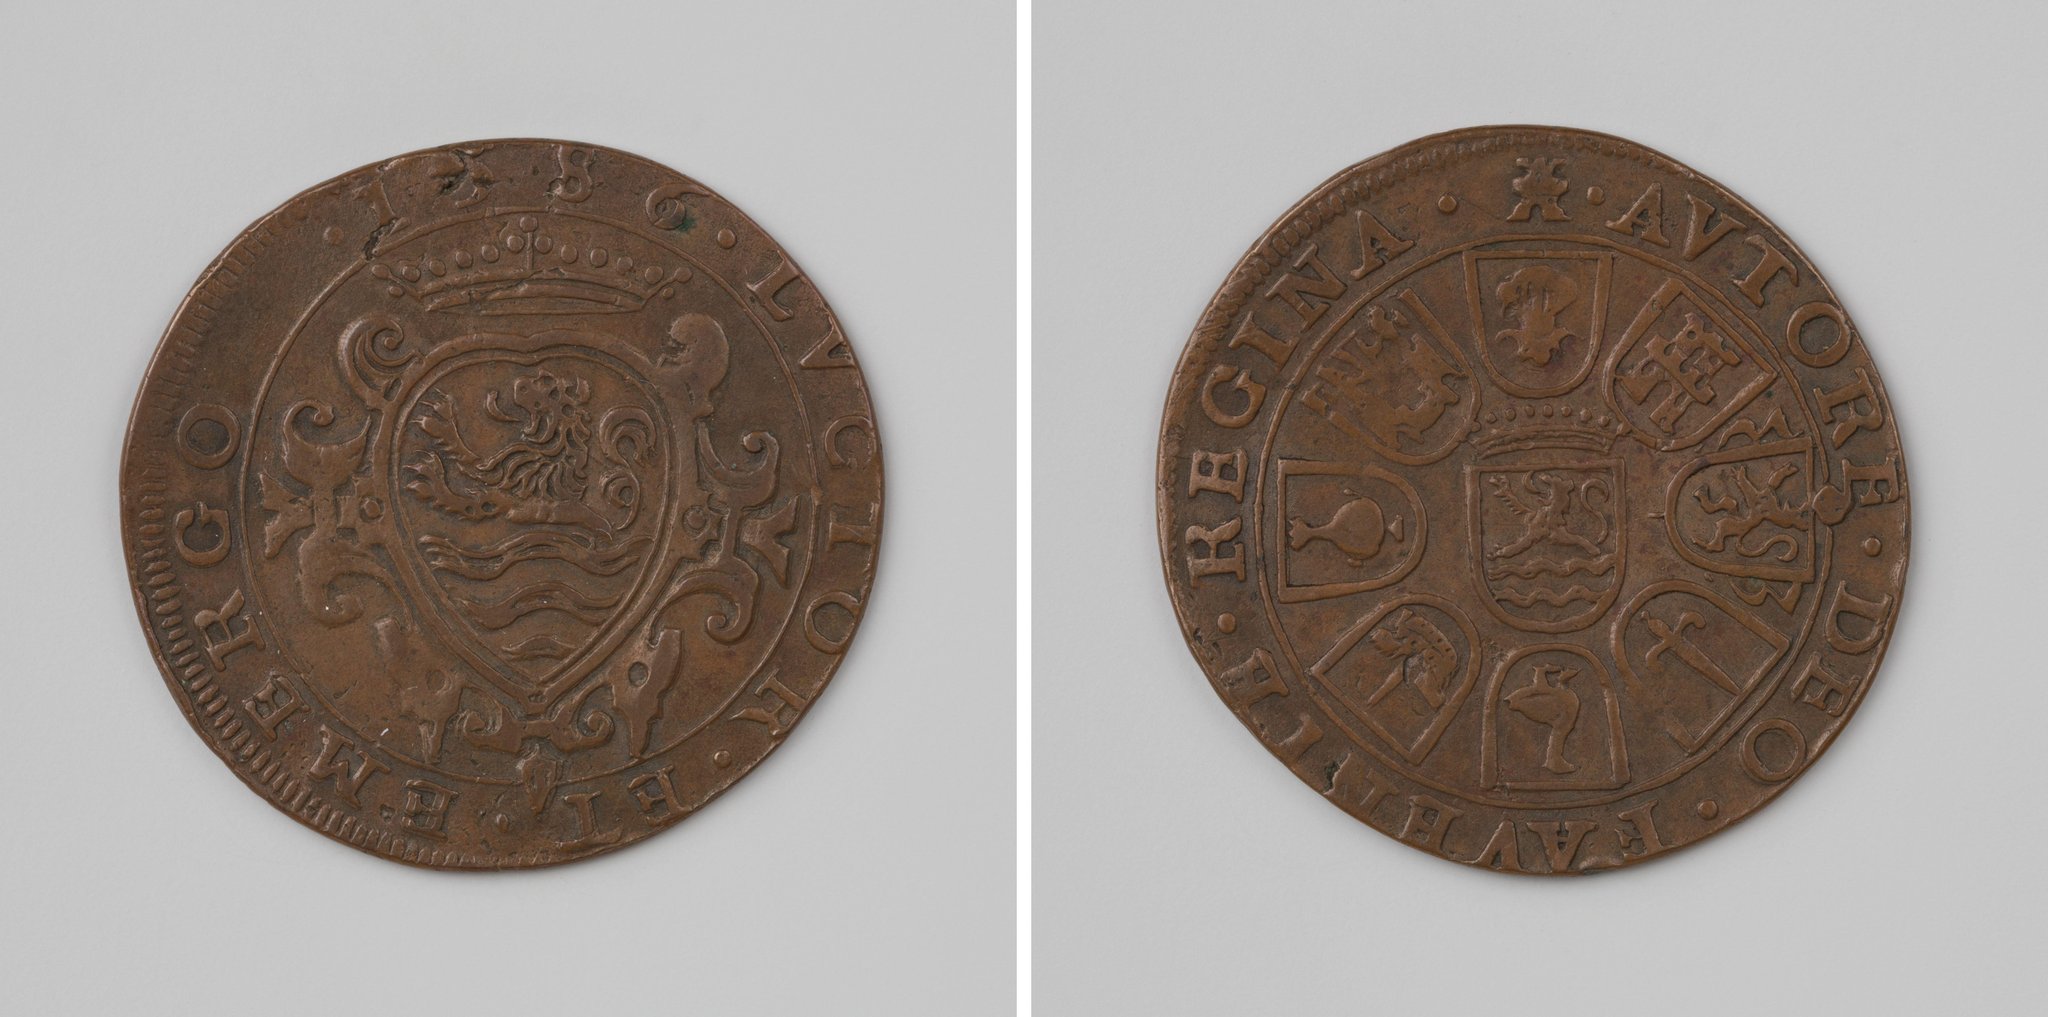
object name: jeton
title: Engelse hulp aan de opstandelingen, rekenpenning van de Staten van Zeeland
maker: Anonymous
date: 1586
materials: copper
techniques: striking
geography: middelburg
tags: zeeland, england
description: Koperen penning. Voorzijde: gekroond wapenschild, omringd door acht wapenschilden binnen omschrift. Keerzijde: gekroond wapenschild in versierd cartouche binnen omschrift